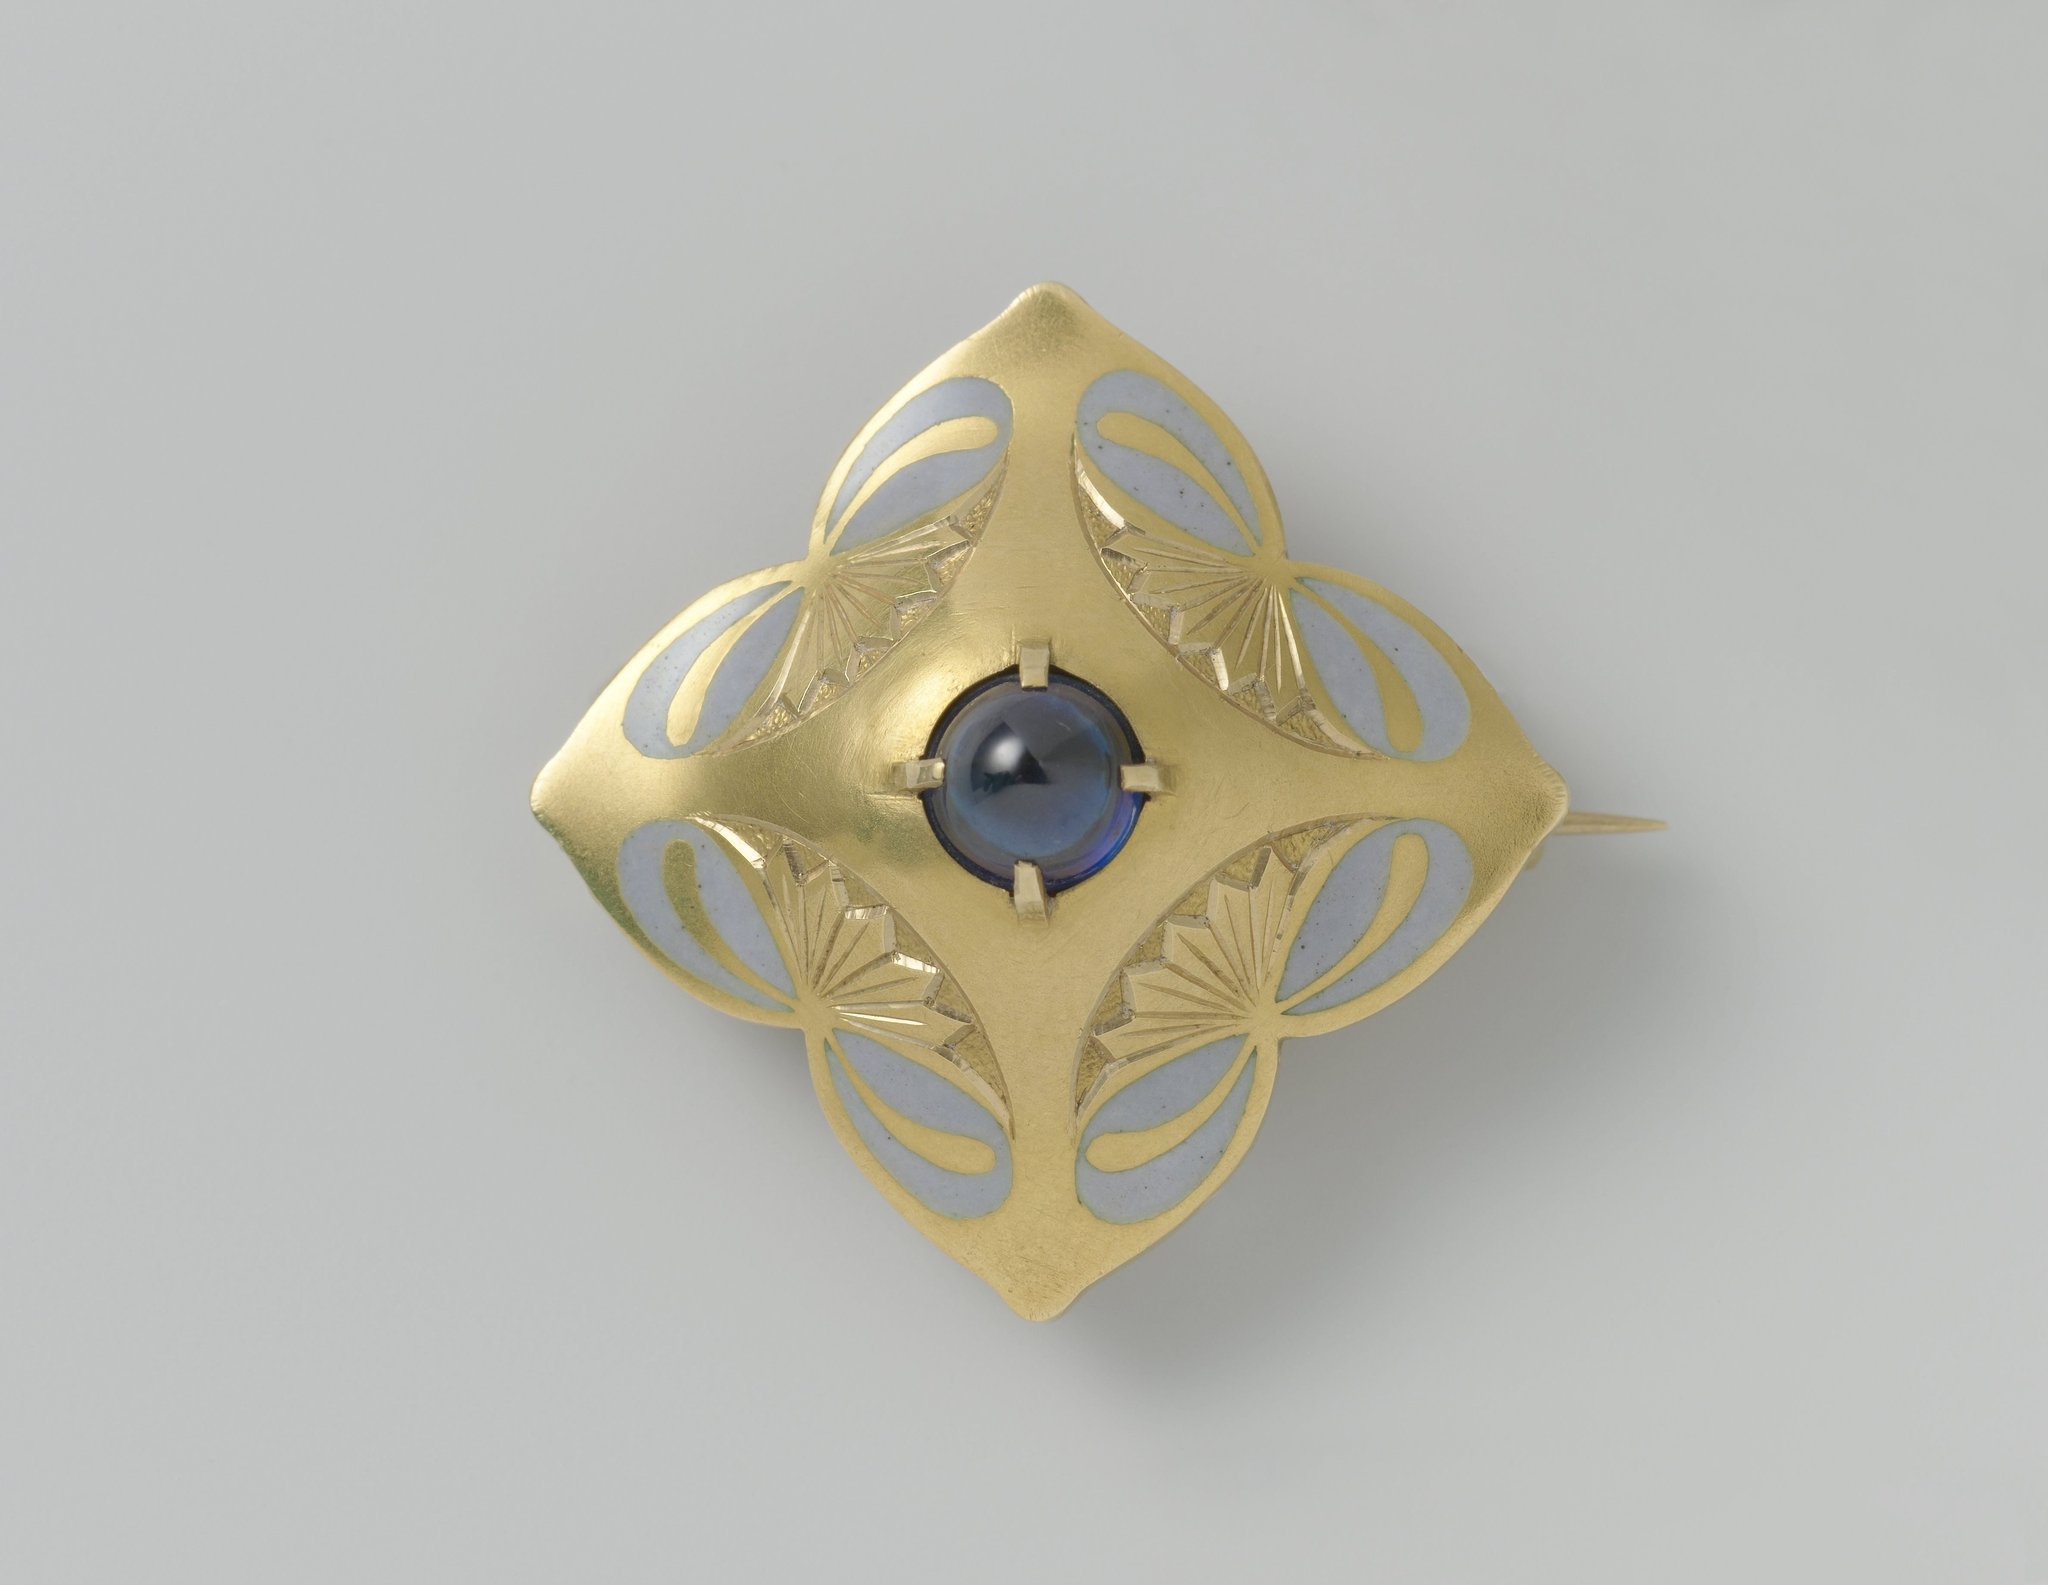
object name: brooch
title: Broche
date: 1908-1911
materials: gold, gemstone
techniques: enameling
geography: amsterdam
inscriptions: alloy mark, alloy mark, maker's mark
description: Jewellery. Gold, silver, enamel and semi-precious stones. Amsterdam, c. 1908 - 1911, by L.W. van Kooten, designed by Bert Nienhuis. Given by the Prins Bernhard Fonds, 1980.